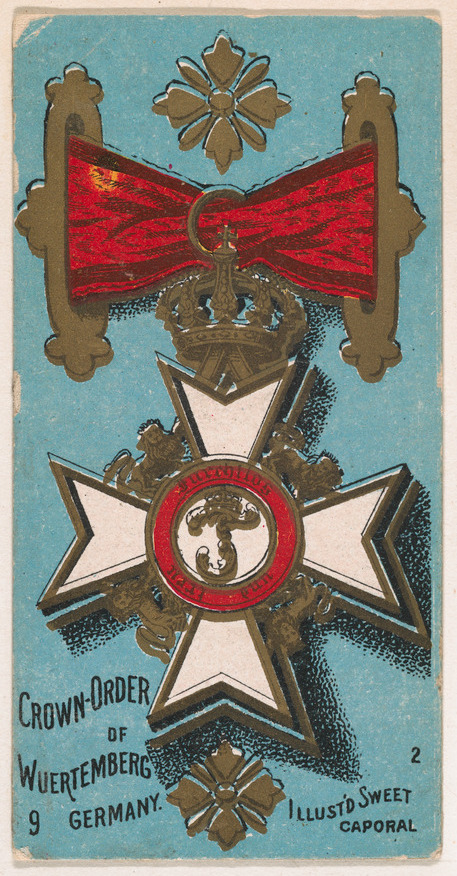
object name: print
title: Crown Order of Wuertemberg, Germany, from the Military Series (N224) issued by Kinney Tobacco Company to promote Sweet Caporal Cigarettes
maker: kinney brothers tobacco company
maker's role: publisher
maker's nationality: american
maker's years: 1869-2011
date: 1888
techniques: color lithograph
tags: coat of arms